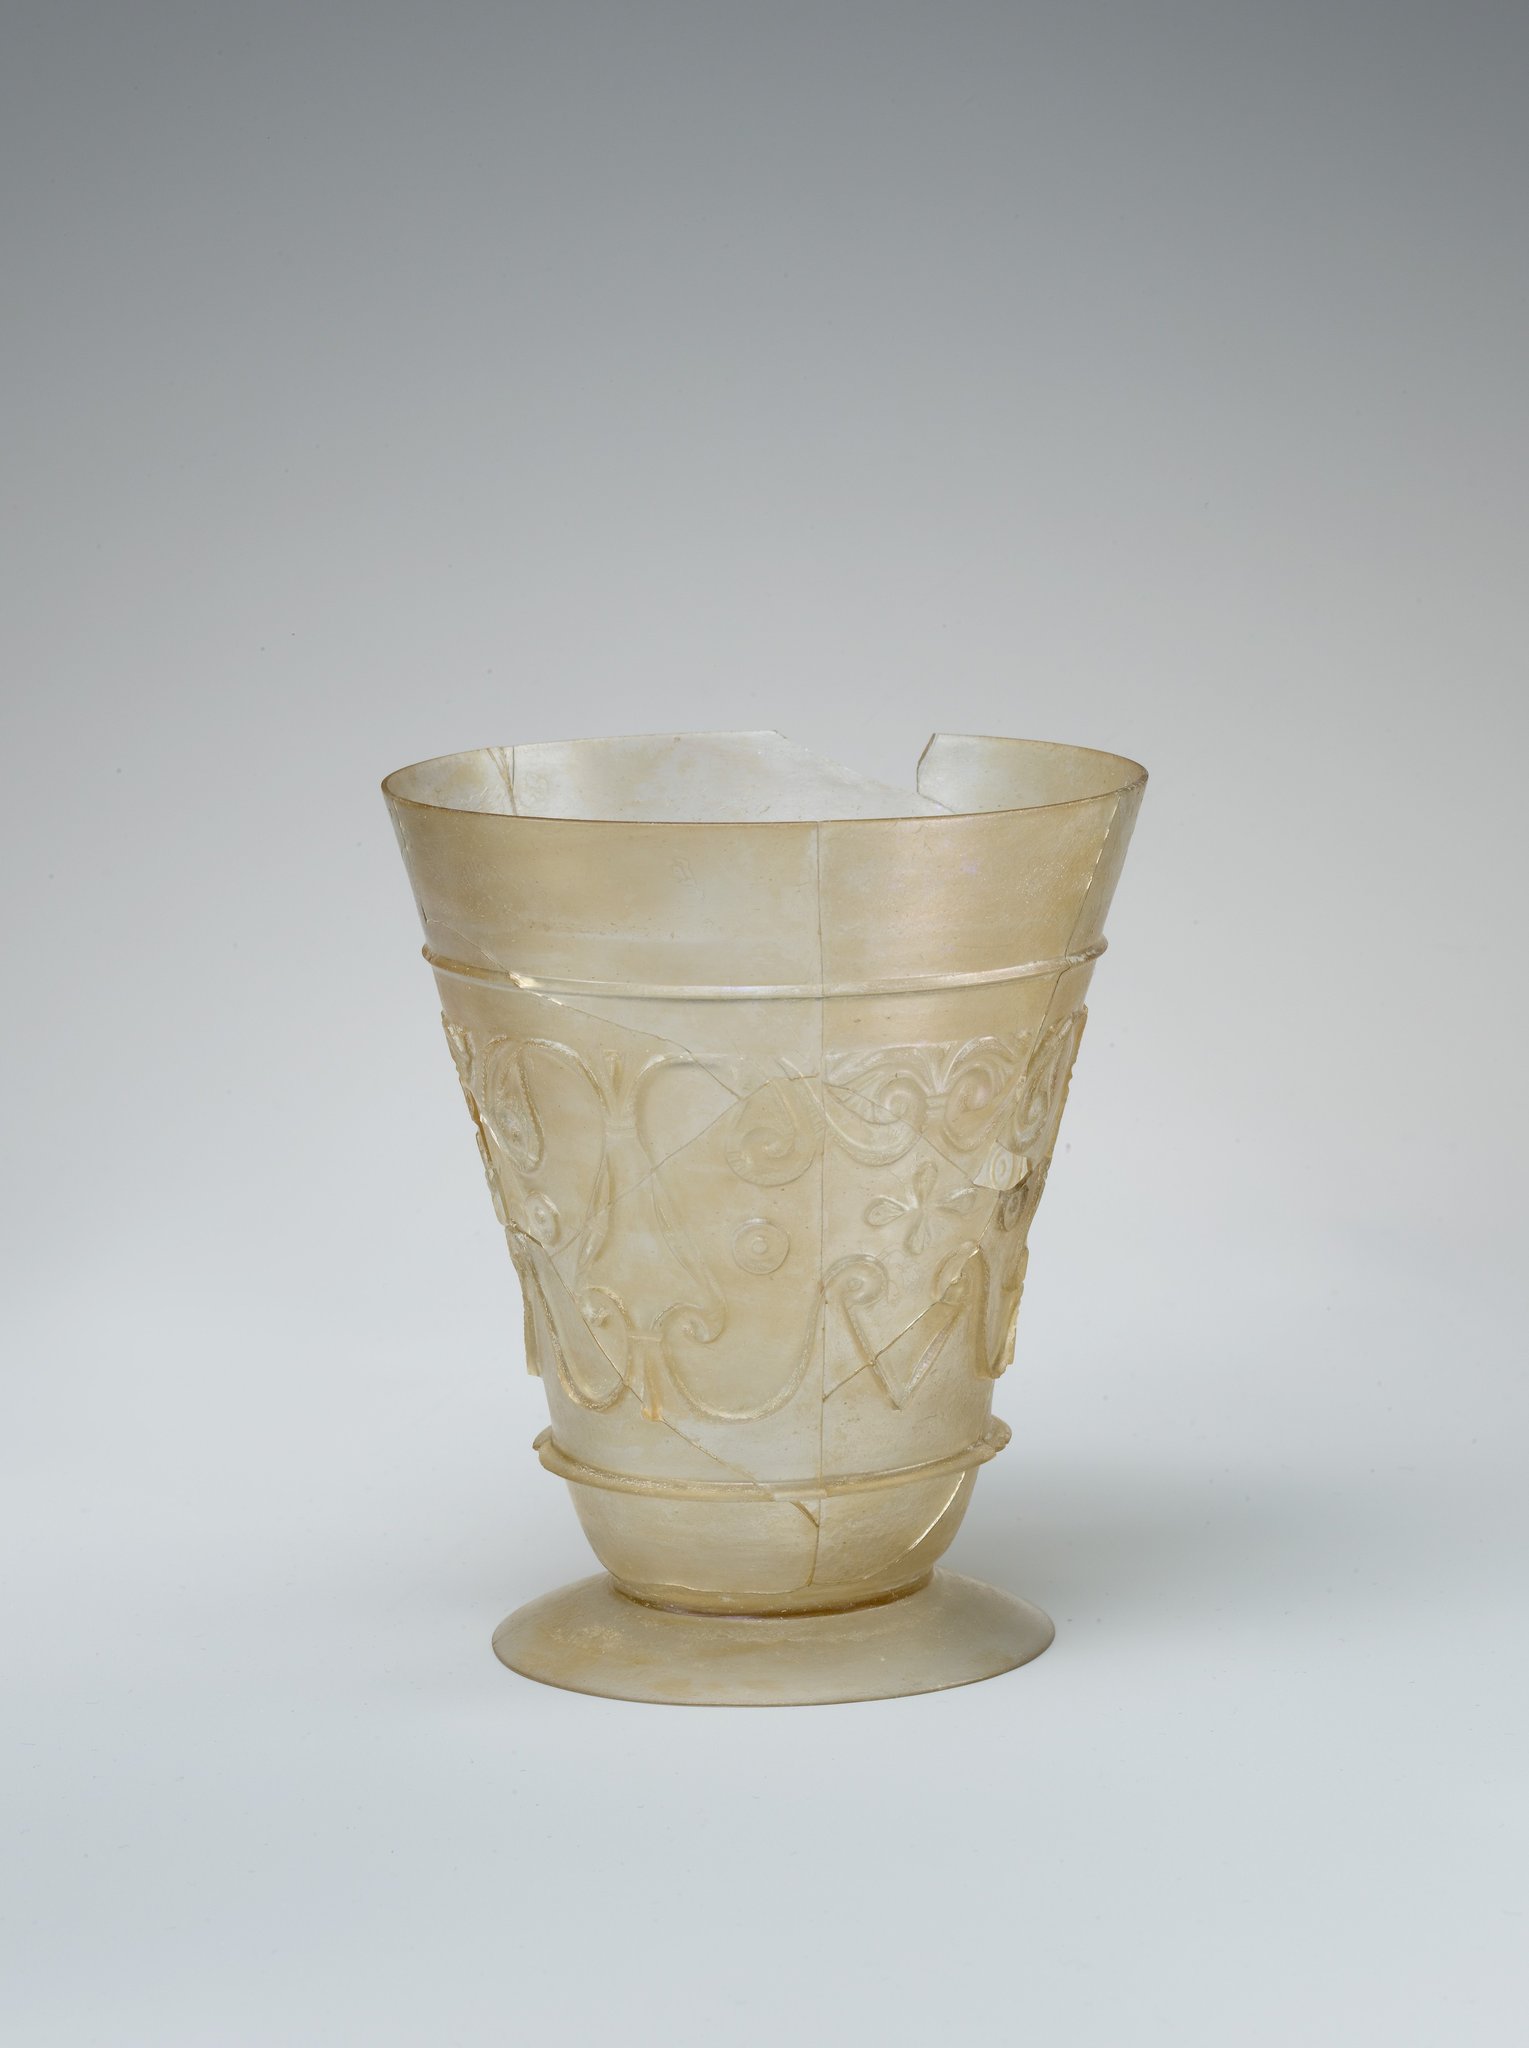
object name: beaker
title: Beaker with Relief-cut Decoration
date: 801-1000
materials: glass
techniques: glassblowing, cutting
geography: iran